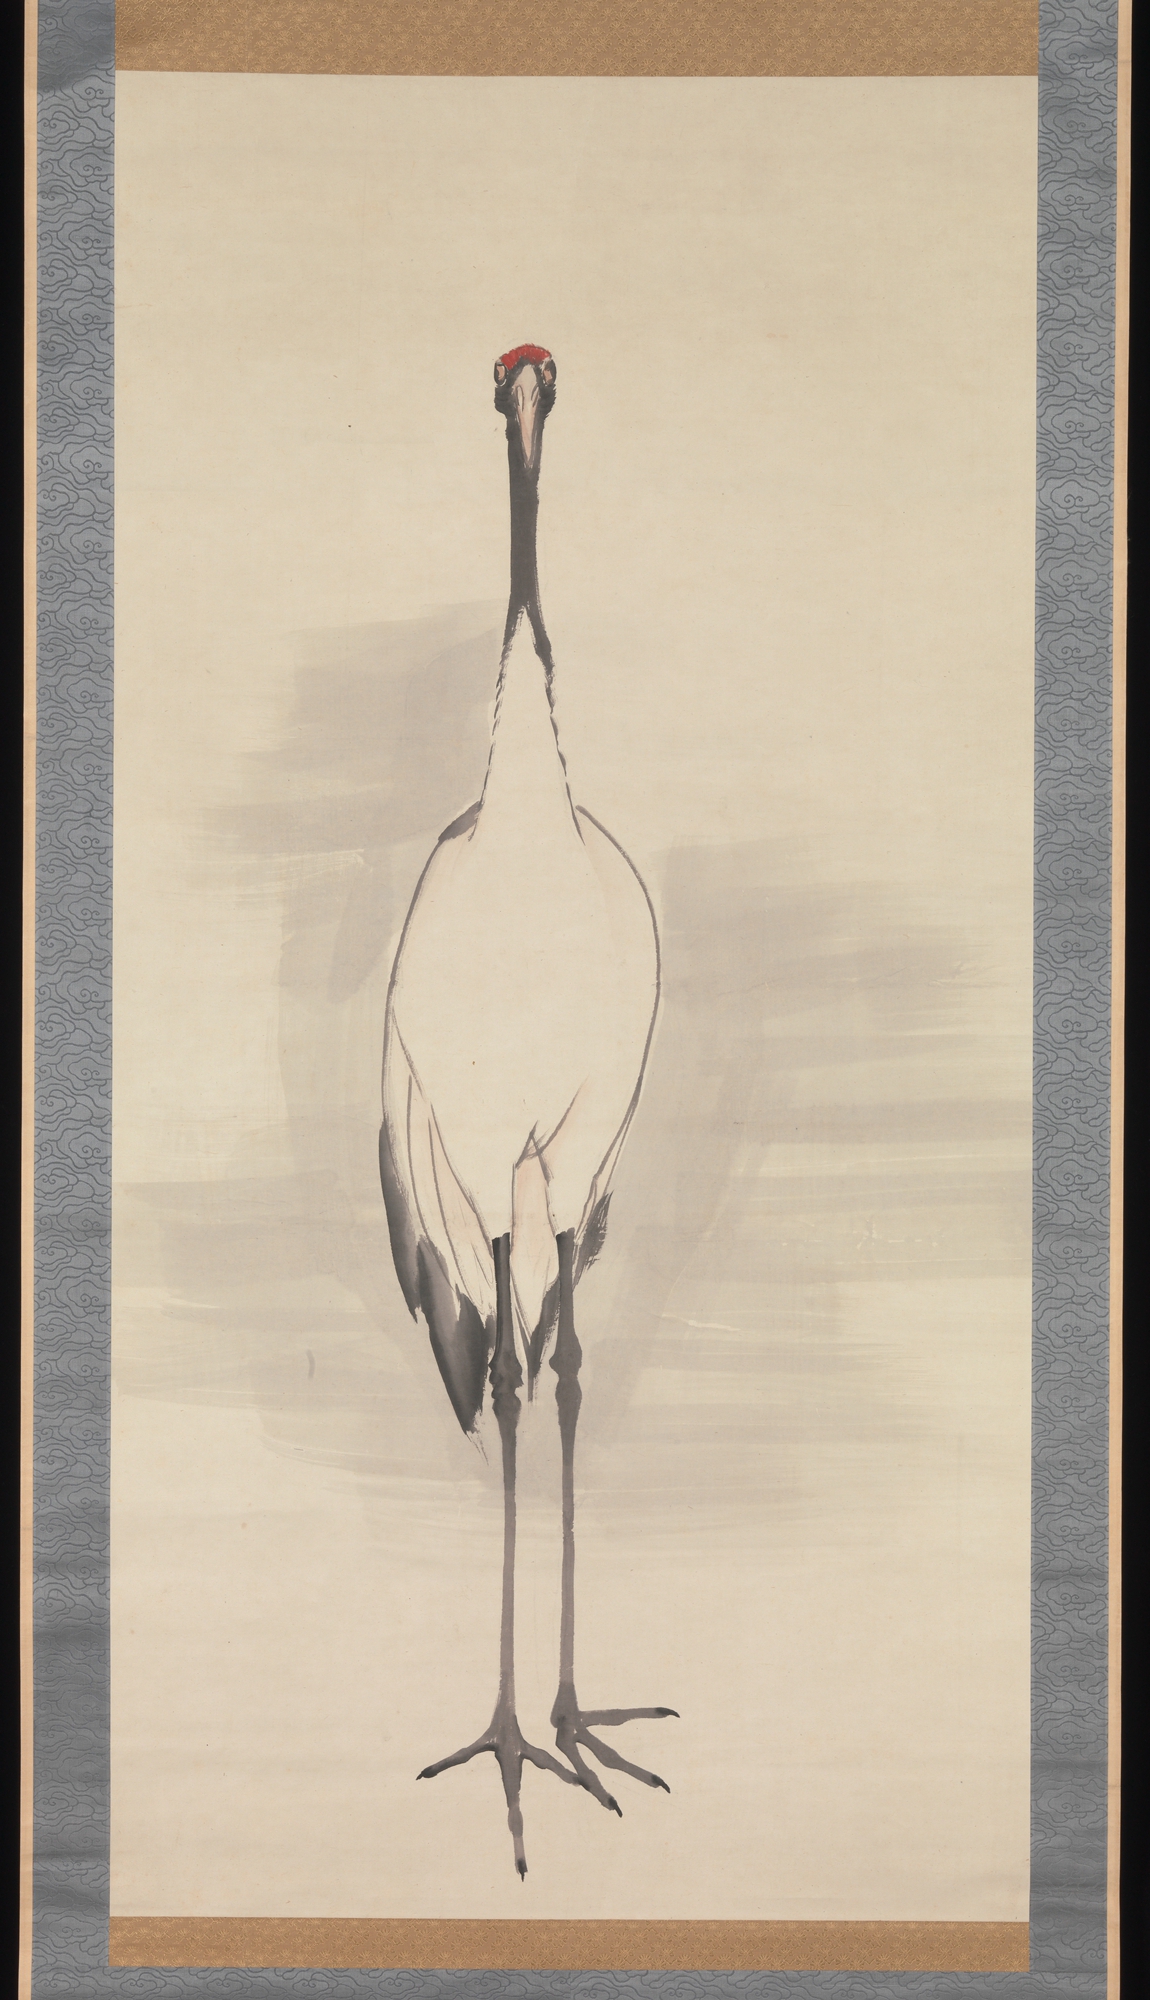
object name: hanging scroll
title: Cranes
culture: japanese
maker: nagasawa rosetsu 長澤蘆雪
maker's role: artist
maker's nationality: japanese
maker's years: 1754-1799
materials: ink, paper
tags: cranes